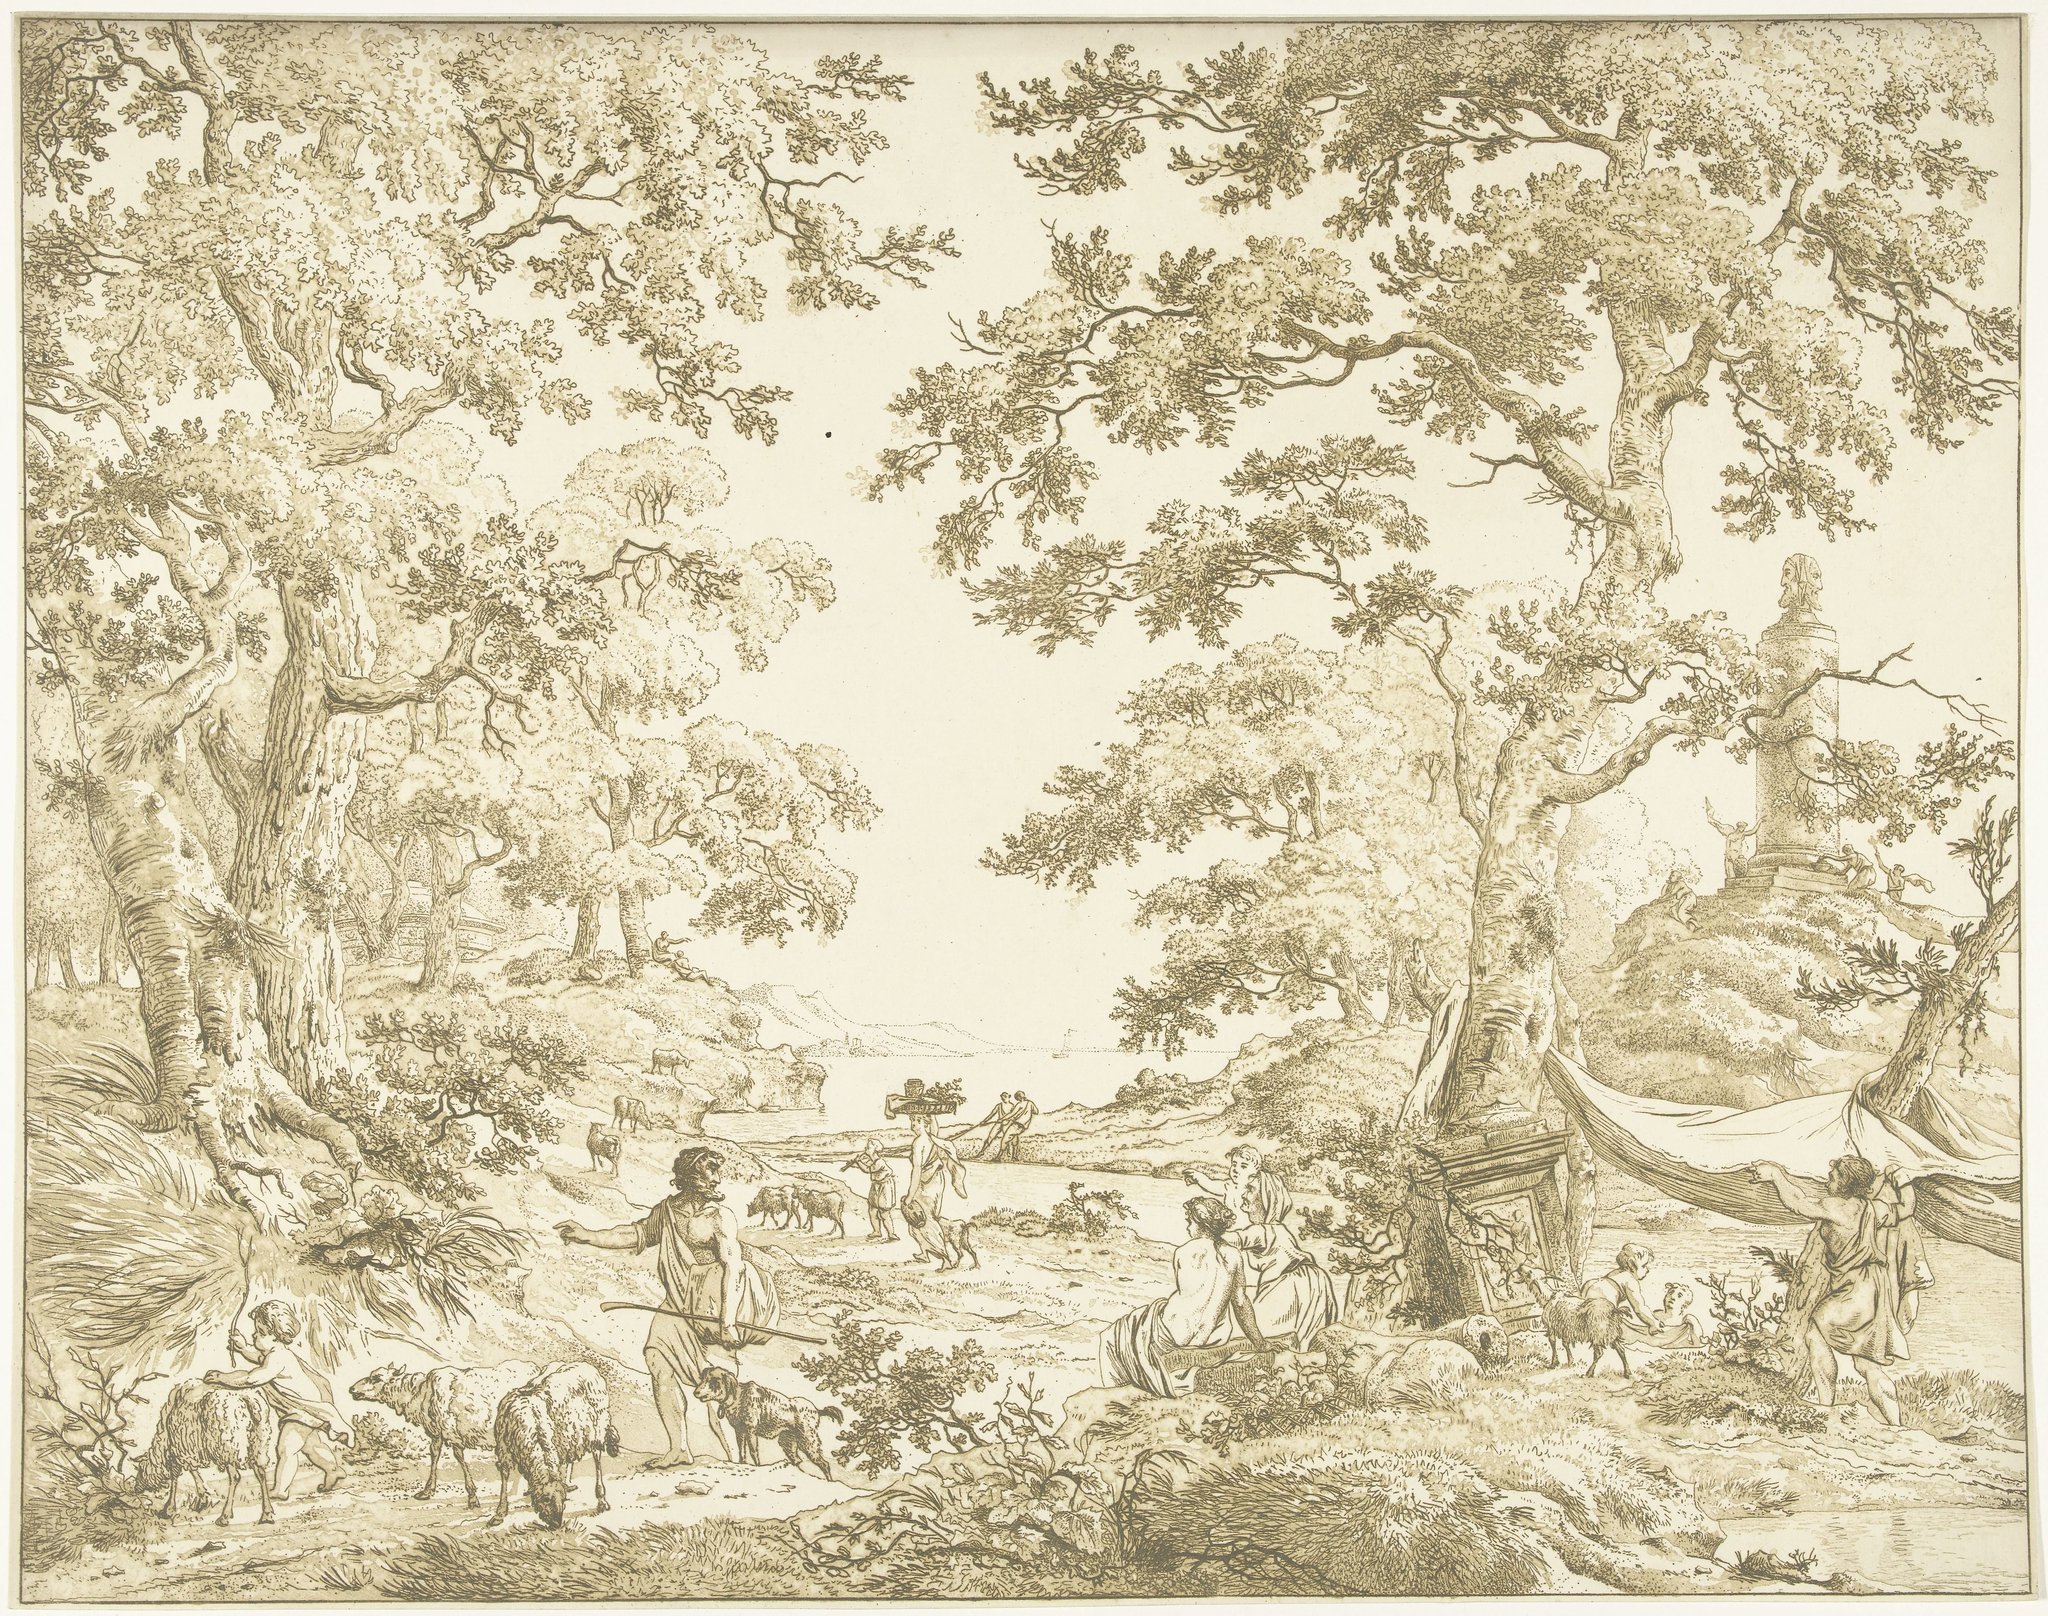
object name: print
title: Arcadisch landschap met Janusbeeld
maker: hermanus fock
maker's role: conservator, draughtsman, painter, print maker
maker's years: 1766-1822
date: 1781-1822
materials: paper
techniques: aquatint, etching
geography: amsterdam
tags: janus' head, two-faced head, pastorals, arcadian scenes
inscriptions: collector's mark: Lugt 2228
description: Landschap met hoge bomen en personen en schapen langs de oever van een rivier. Op de voorgrond een schaapsherder met een hond en een kind tussen drie schapen. Op de achtergrond, rechts, een Janusbeeld op een heuvel.